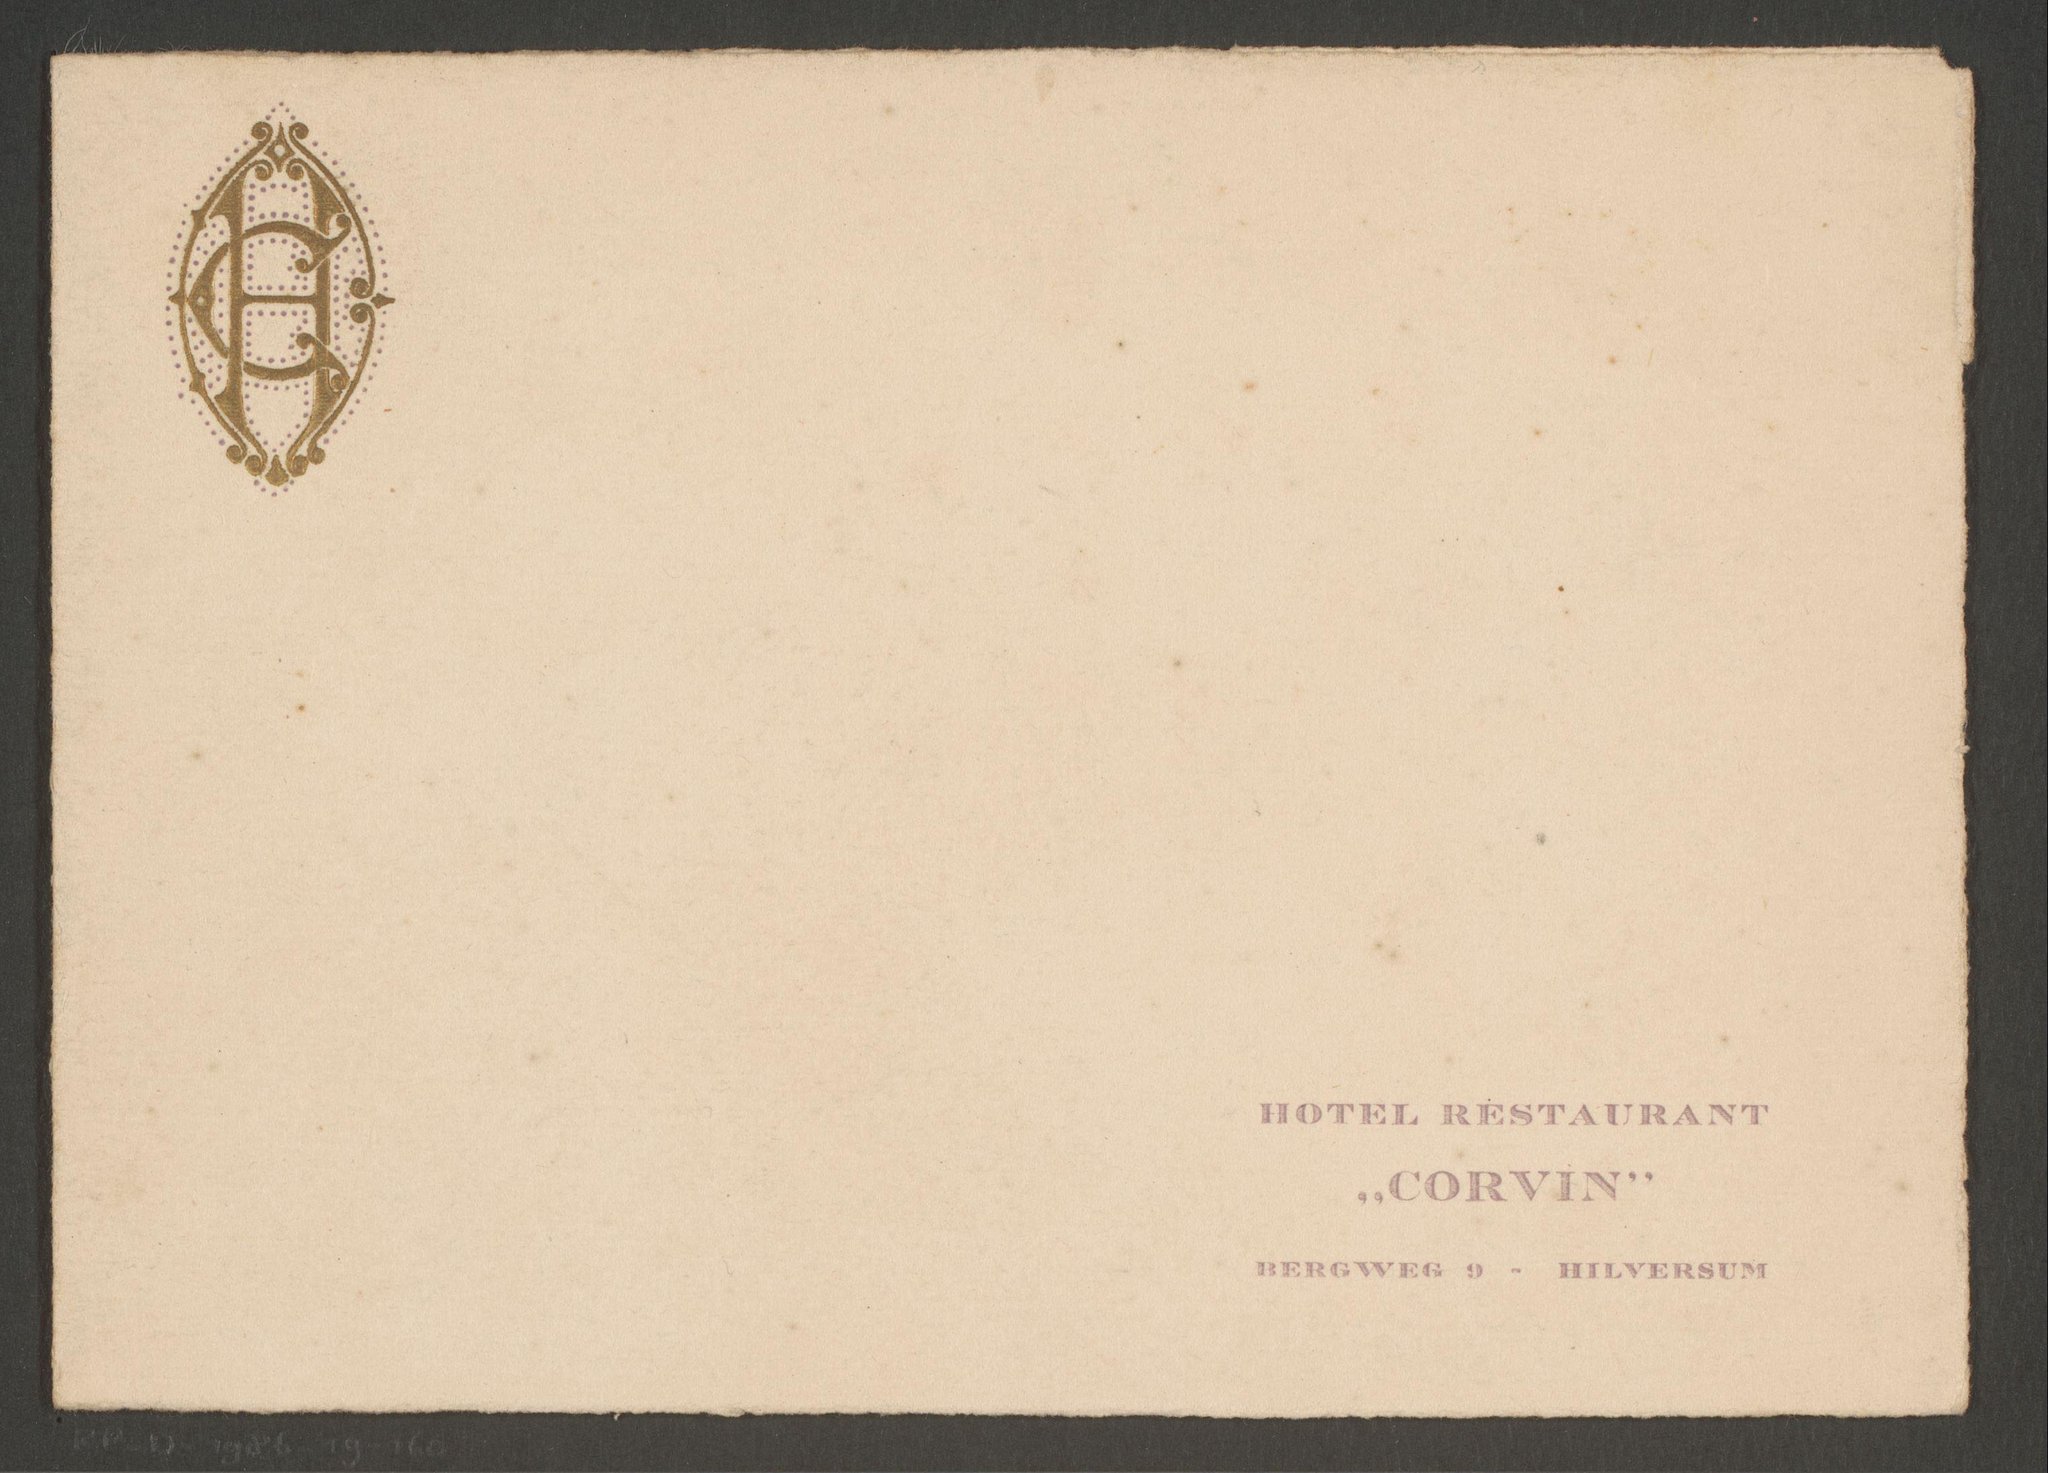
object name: print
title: Reclamekaart voor hotel-restaurant Corvin te Hilversum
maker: reinier willem petrus de vries (1874-1953)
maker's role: draughtsman, print maker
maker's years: 1874-1953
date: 1884-1952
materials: paper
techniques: relief print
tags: magic mathematical figures; magic numbers, words, monograms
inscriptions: collector's mark: ‘R:MVS.’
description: Monogram met de letters H en C in een ovaal.